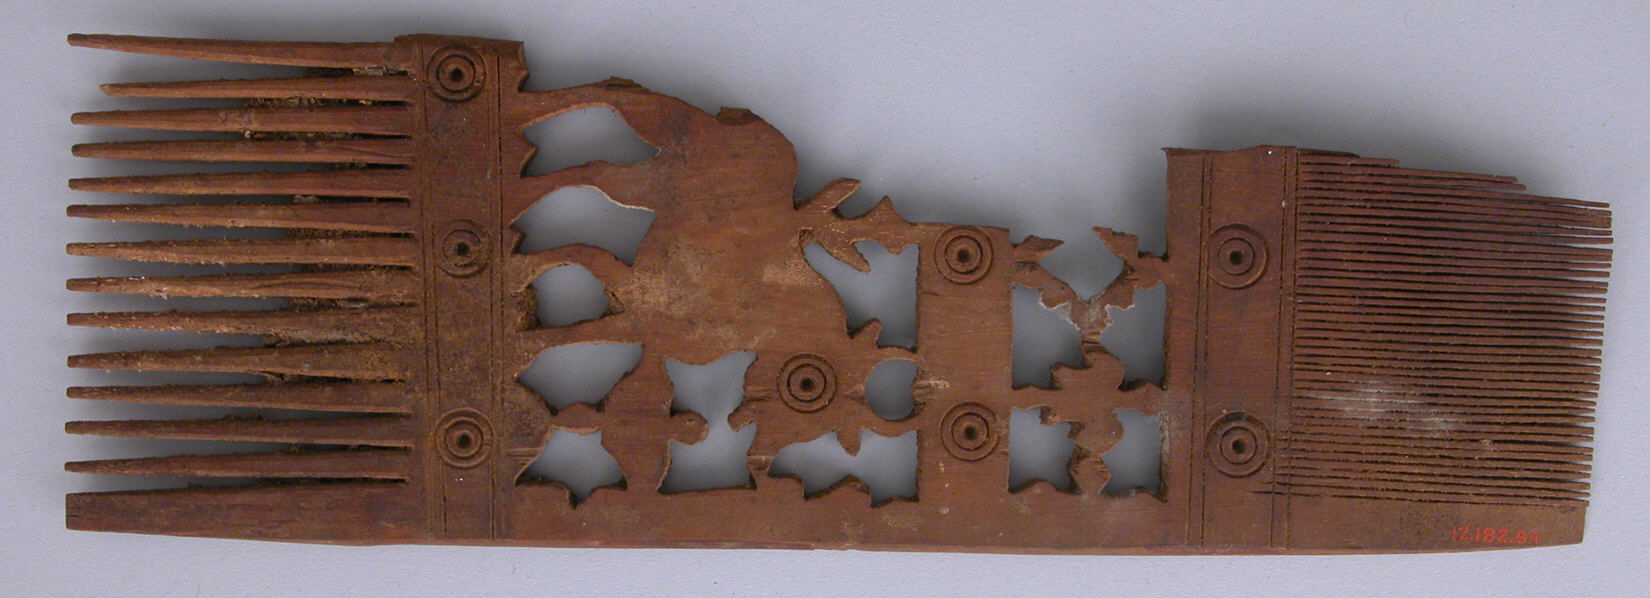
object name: comb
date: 601-800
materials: wood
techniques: carving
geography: egypt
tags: animals